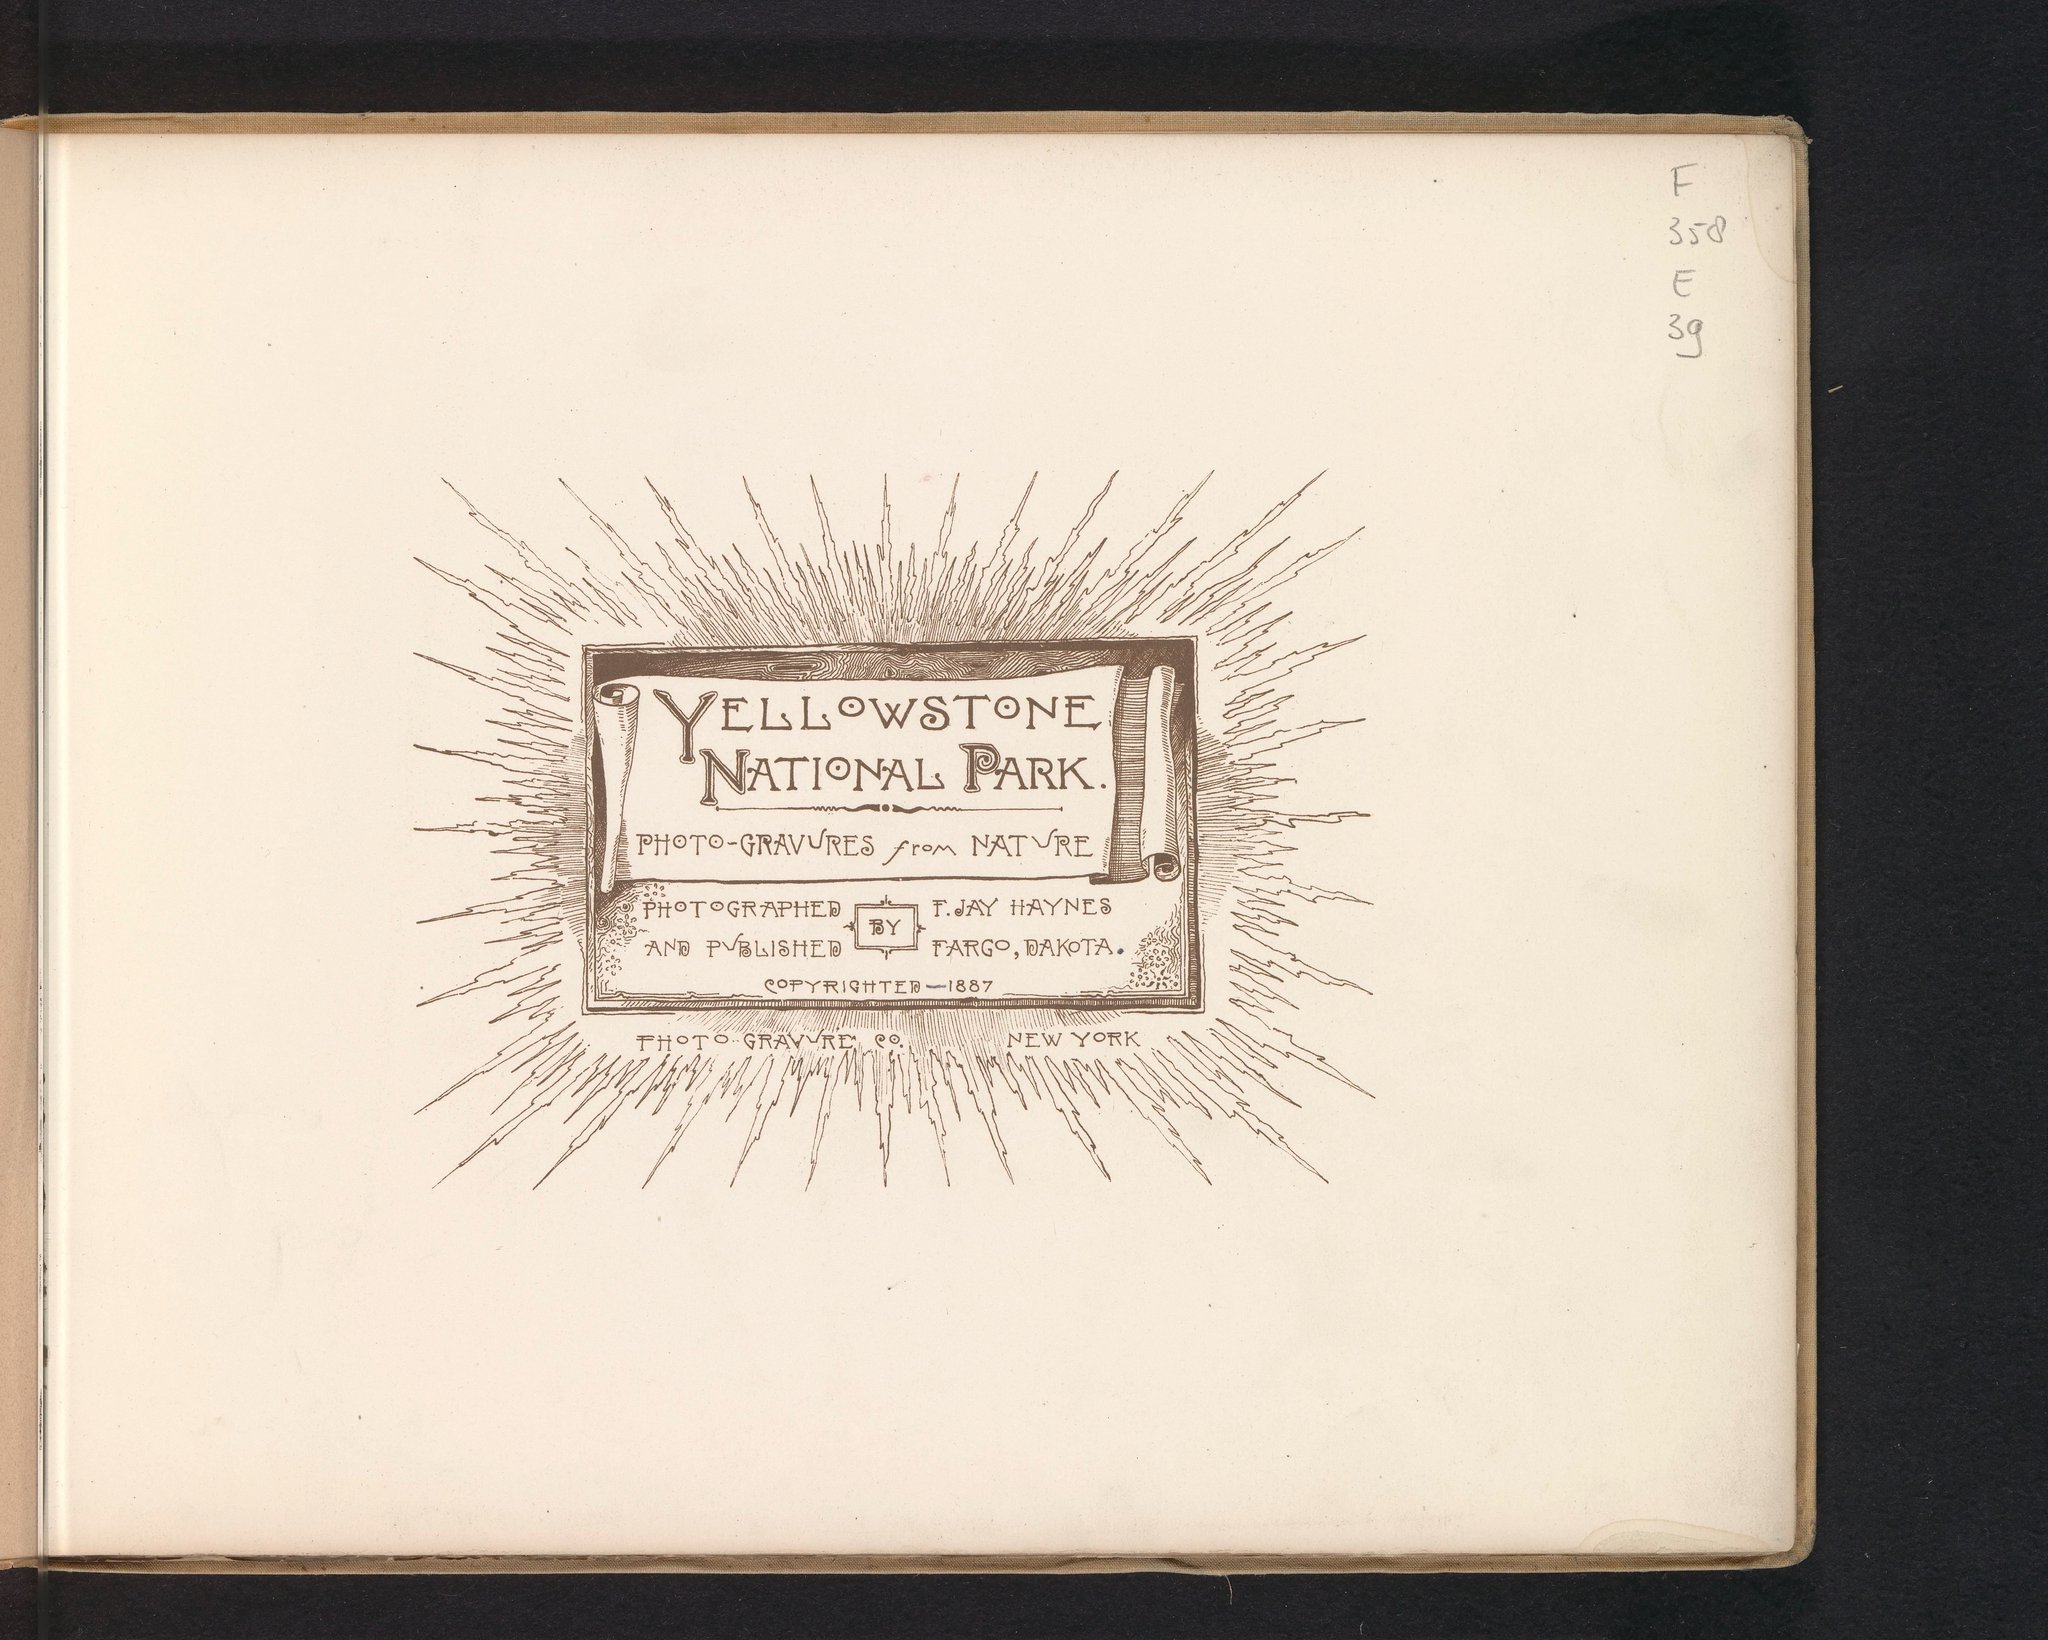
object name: book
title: Yellowstone National Park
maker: frank jay haynes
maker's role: fotograaf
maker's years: 1853-1921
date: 1887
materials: cardboard, linen, paper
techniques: photoaquatint, printing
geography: fargo